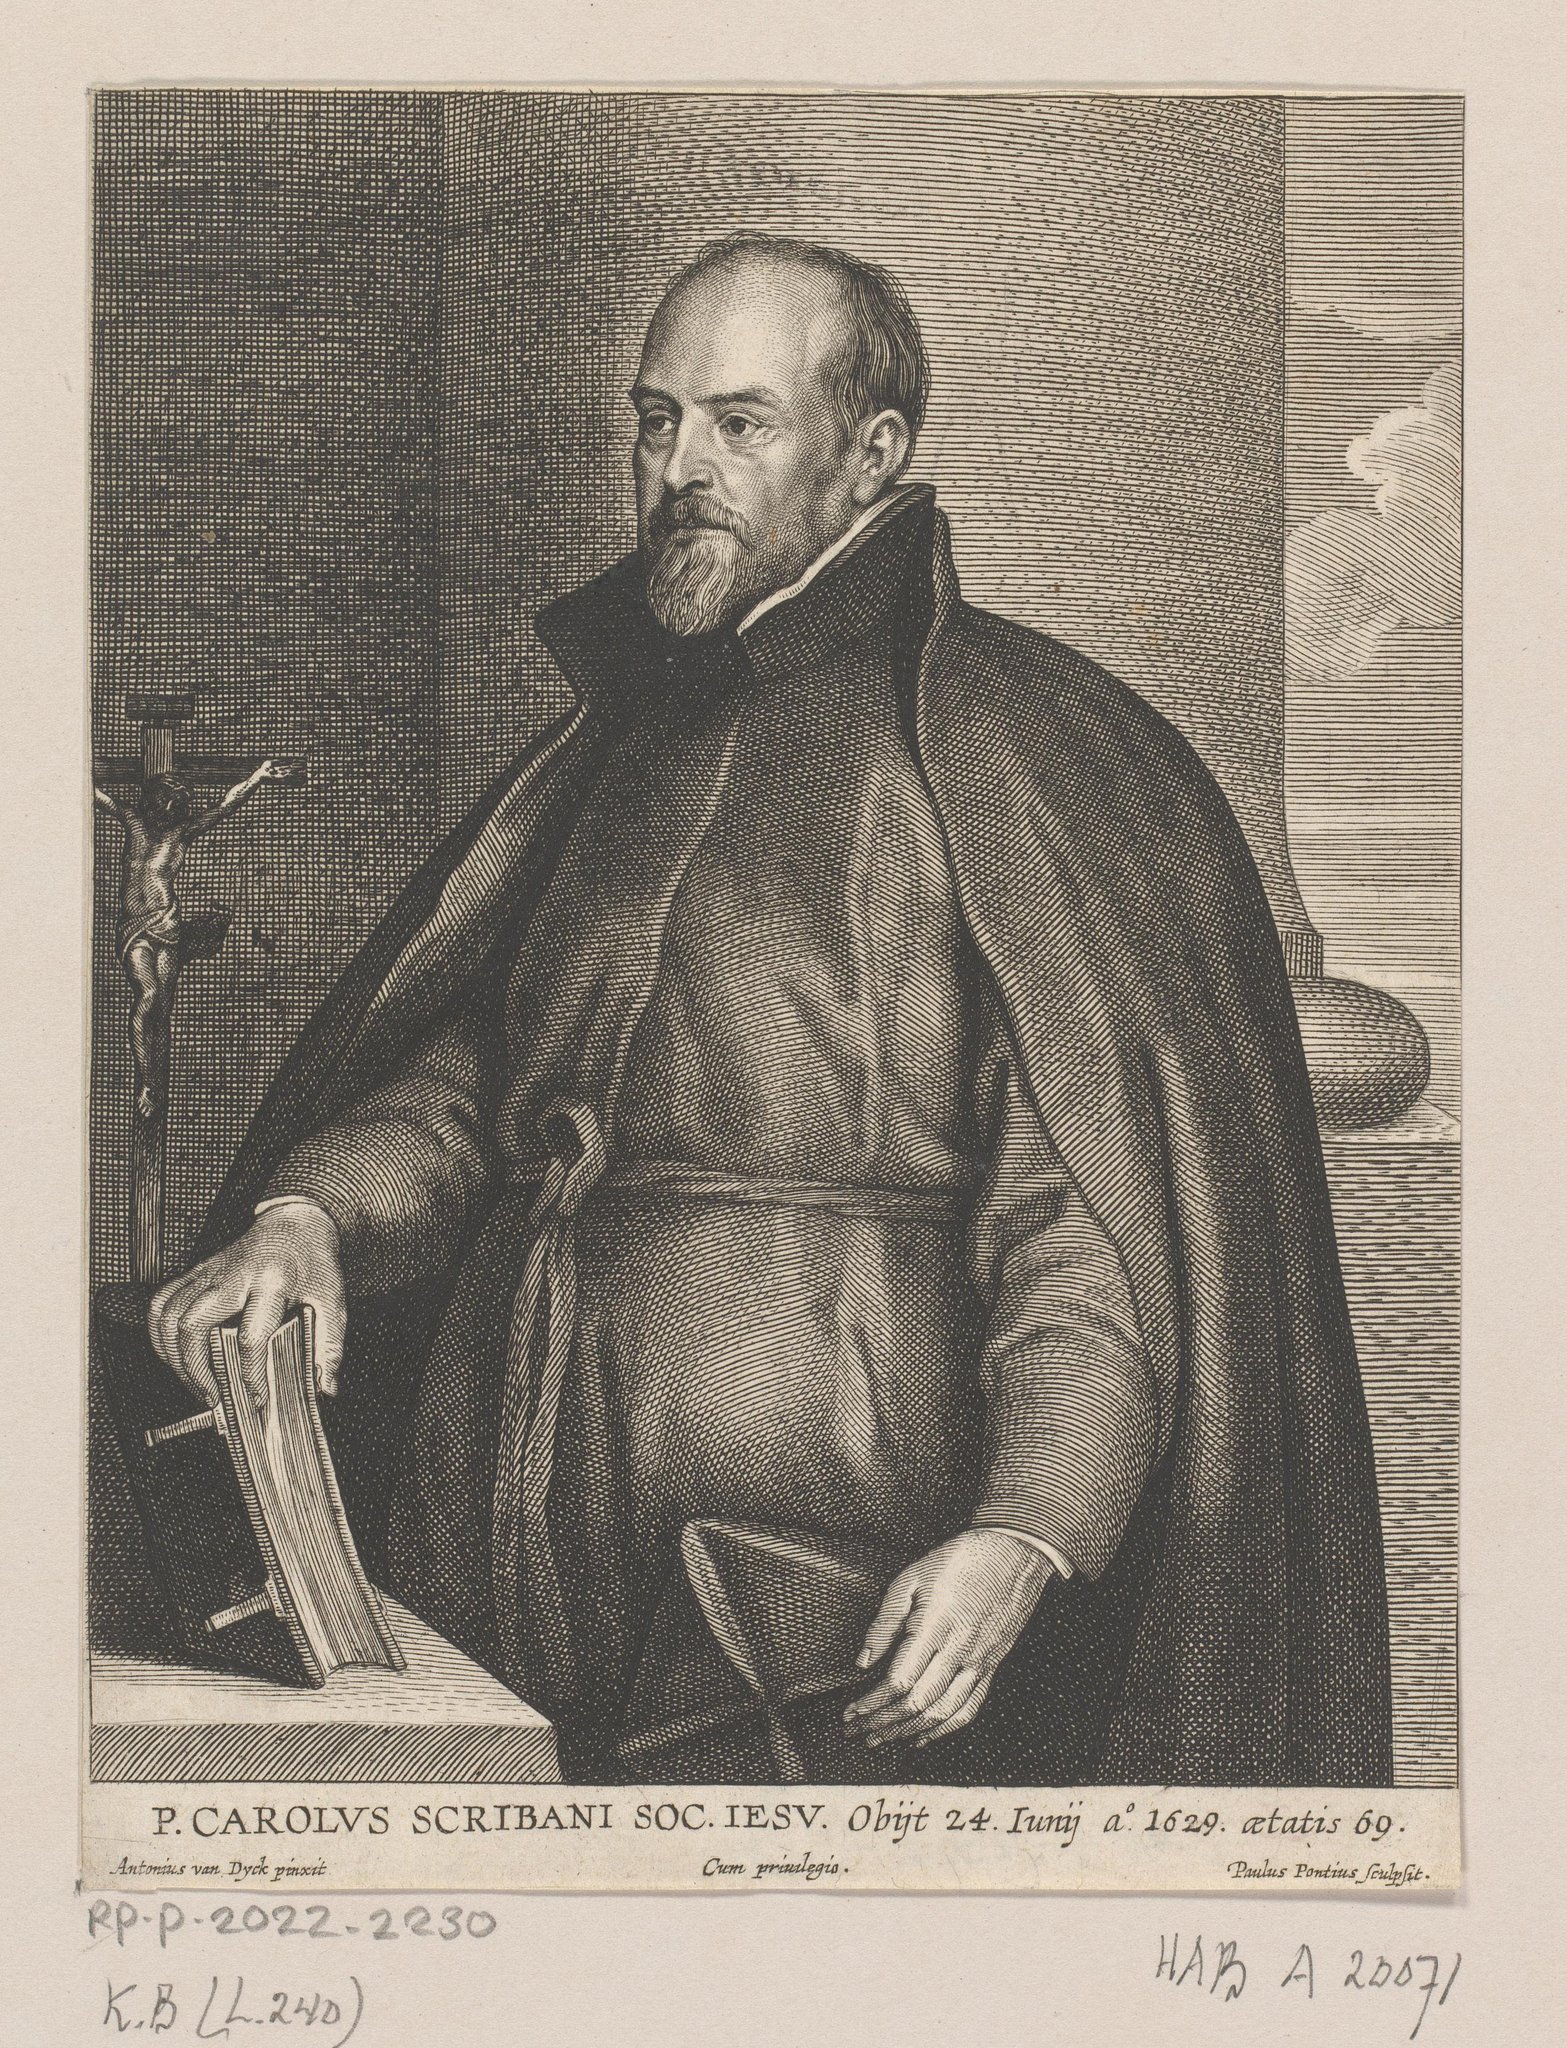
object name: print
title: Portret van Carolus Scribani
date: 1629-1657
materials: paper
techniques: engraving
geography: antwerp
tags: brussels, antwerp, priest, historical persons, professor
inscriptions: collector's mark: Lugt 240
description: Met eenregelig onderschrift in het Latijn.